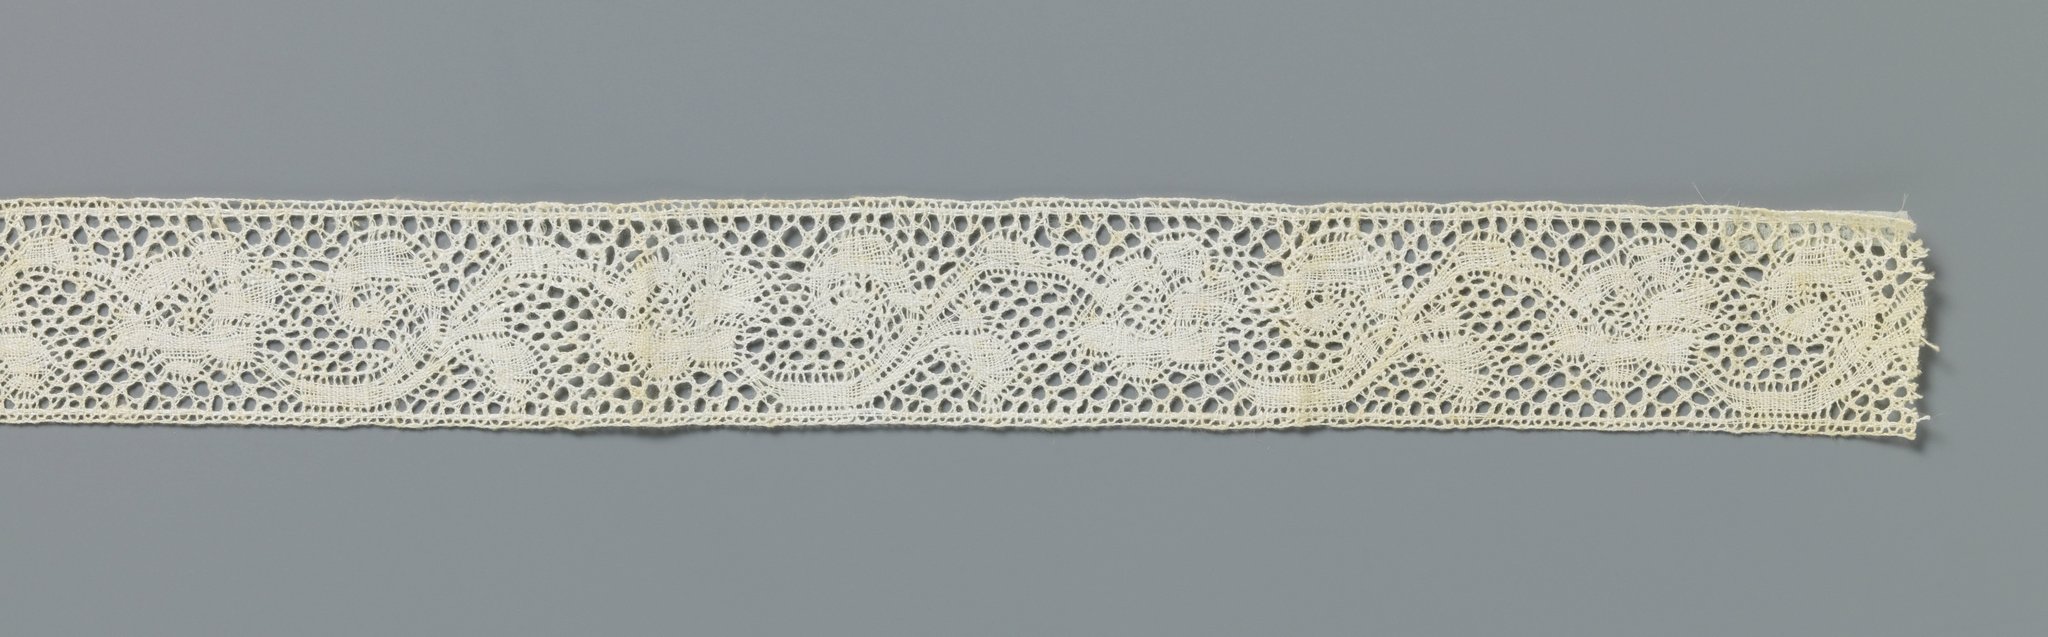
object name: strip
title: Strook kloskant met een rij liggende s-vormige bloemstengels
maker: Anonymous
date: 1900-1909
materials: cotton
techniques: lace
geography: europe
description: Strook naturelkleurige Hollandse kloskant. Het zich herhalende patroon bestaat uit een rij liggende s-vormige bloemstengels, met aan weerszijden van elke stengel een omkrullend blad en aan het uiteinde een rond bloemhart met vijf lobben. De opeenvolgende bloemstengels raken elkaar bij het begin en eind en vormen zo een doorgaand golvend patroon. De motieven zijn gewerkt in linnenslag met opengewerkte randjes en zijn met elkaar verbonden door een traliegrond, een vijfgaatjesgrond. Boven- en onderzijde van de strook zijn recht afgewerkt.